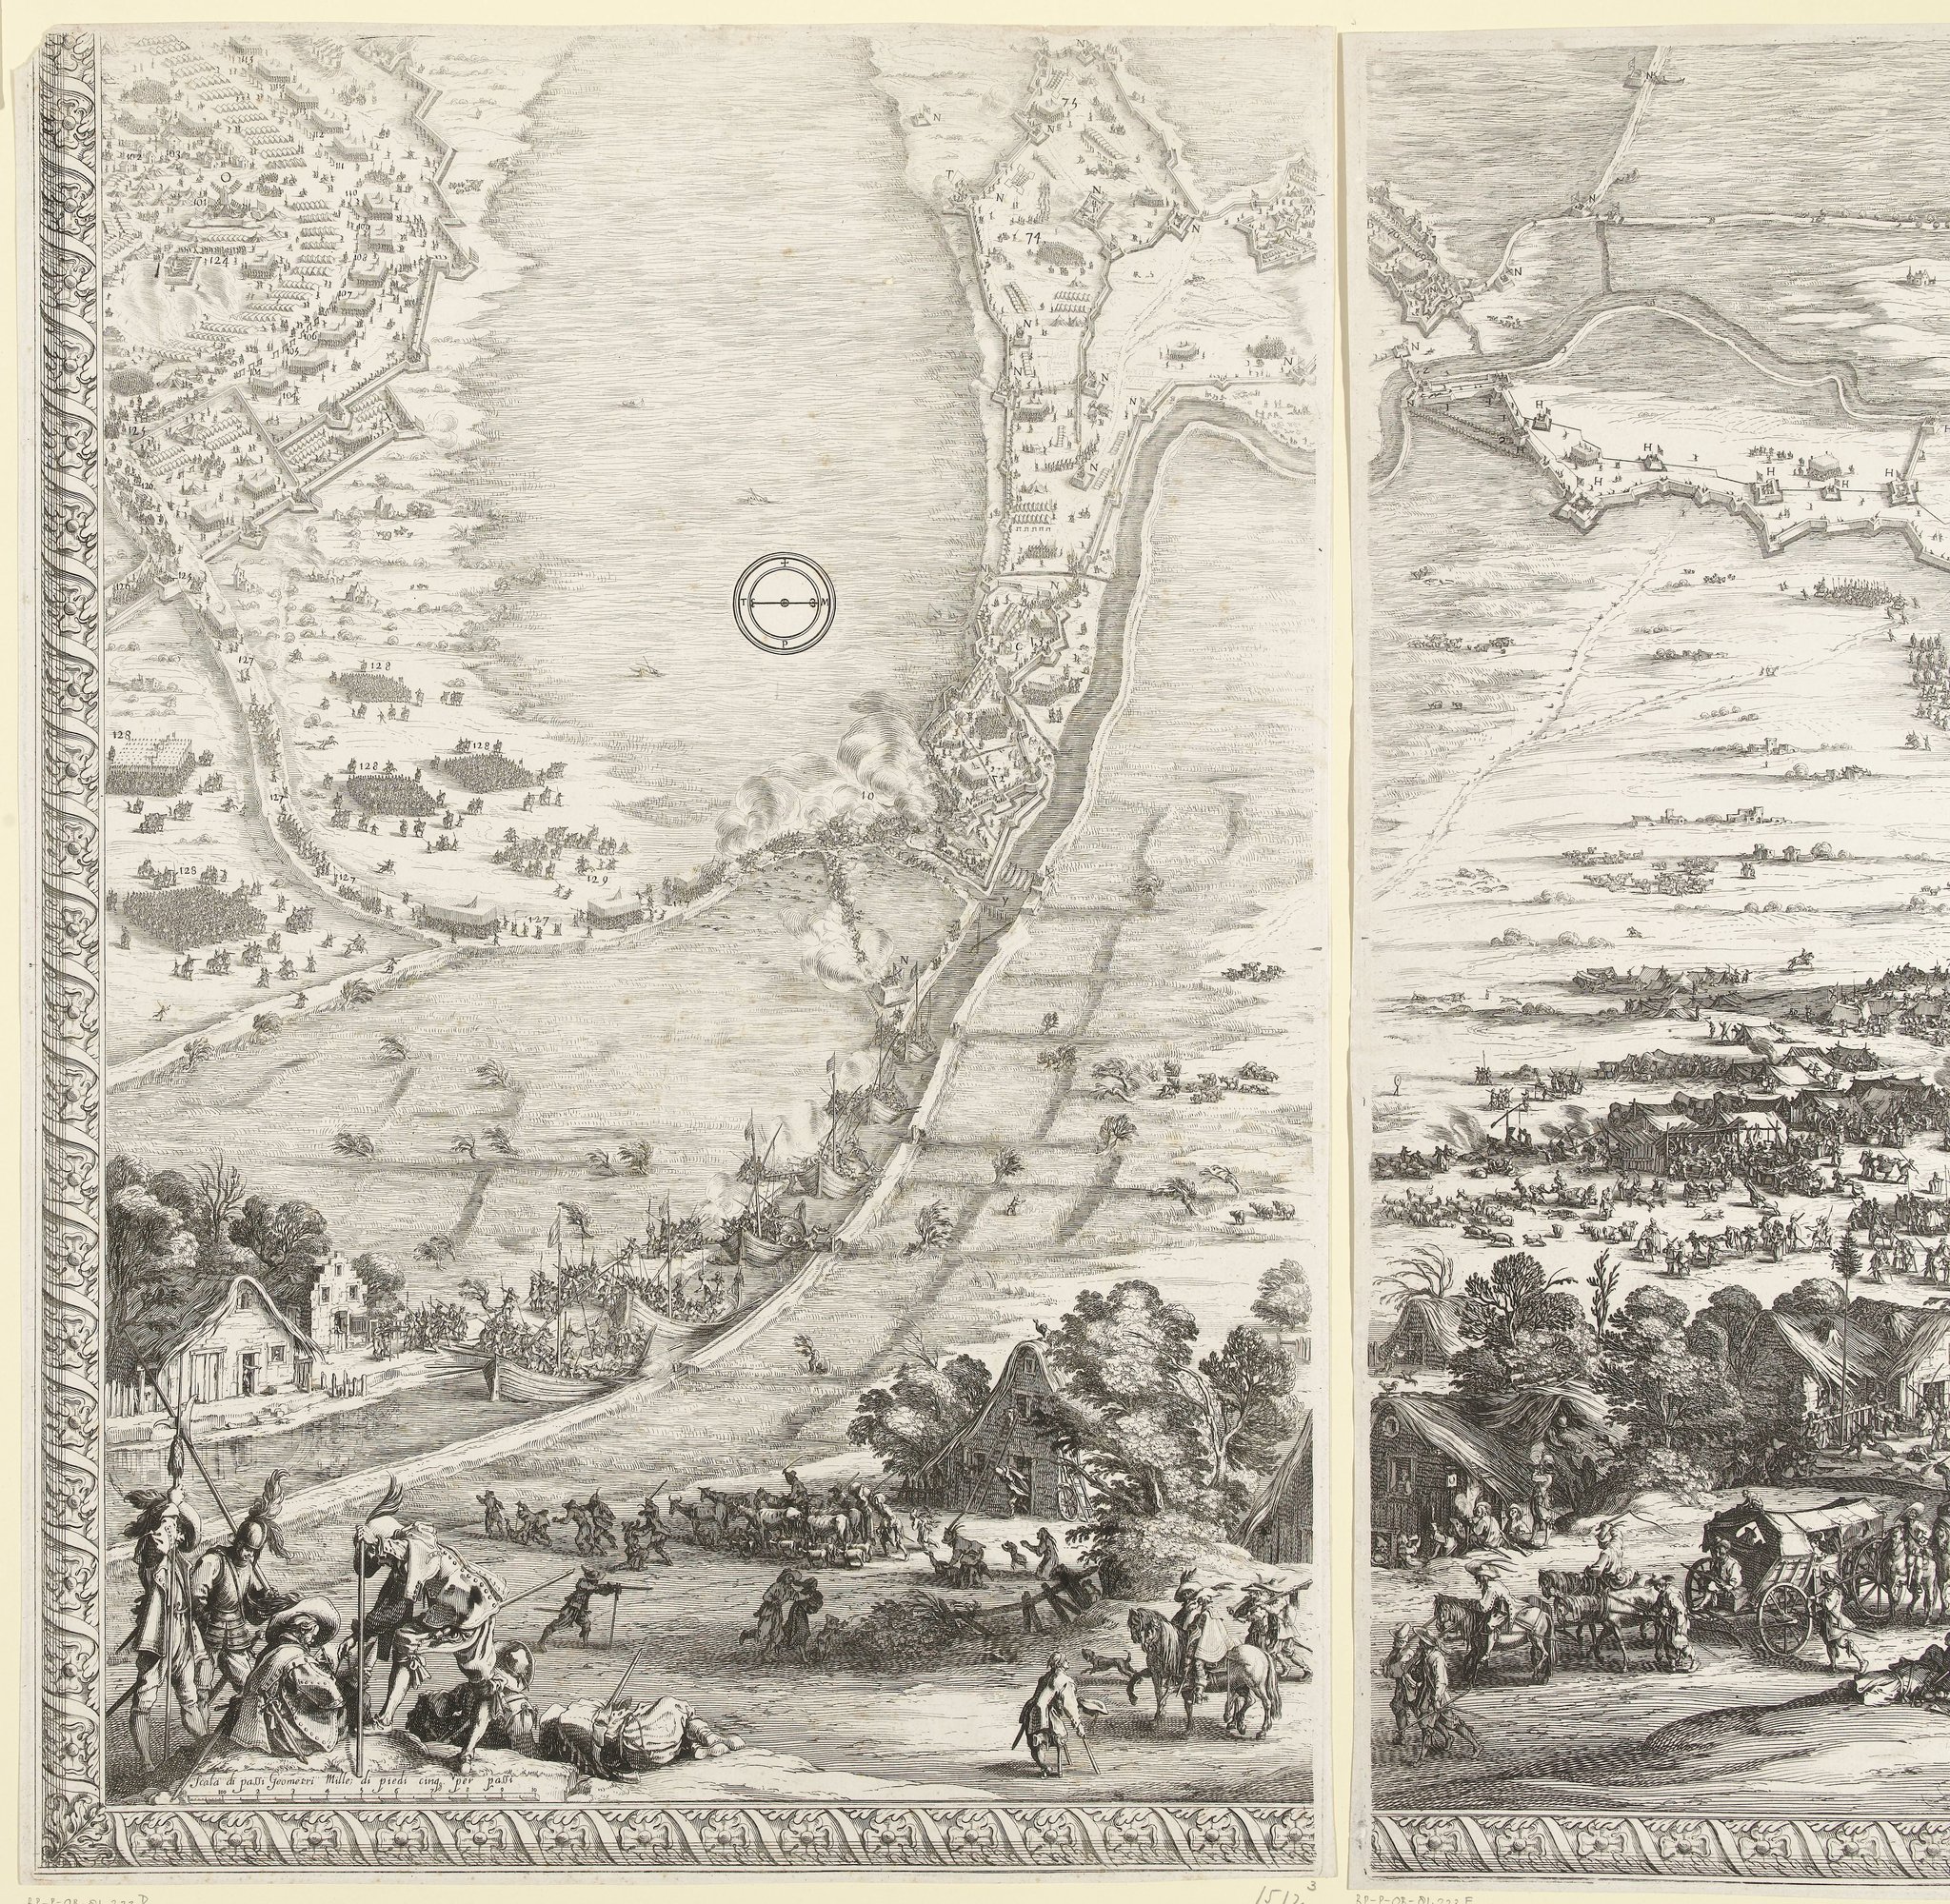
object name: history print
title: Beleg van Breda, 27 augustus 1624-5 juni 1625 (deel linksonder)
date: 1628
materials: paper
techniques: etching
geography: france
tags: (military) camp with tents, maps of separate countries or regions, plundering ~ soldiers, siege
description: Grote voorstelling in zes bladen van het beleg van de stad Breda in de jaren 1624 en 1625 door de Spanjaarden onder aanvoering van Ambrogio Spinola. Blad linksonder. Op dit blad een deel van de belegeringswerken en kampementen om Breda. Voorts op de voorgrond een (deel van een) dorpje dat door soldaten geplunderd wordt, en helemaal vooraan links enkele soldaten en ingenieurs. Links van en onder de voorstelling een ornamentele rand.